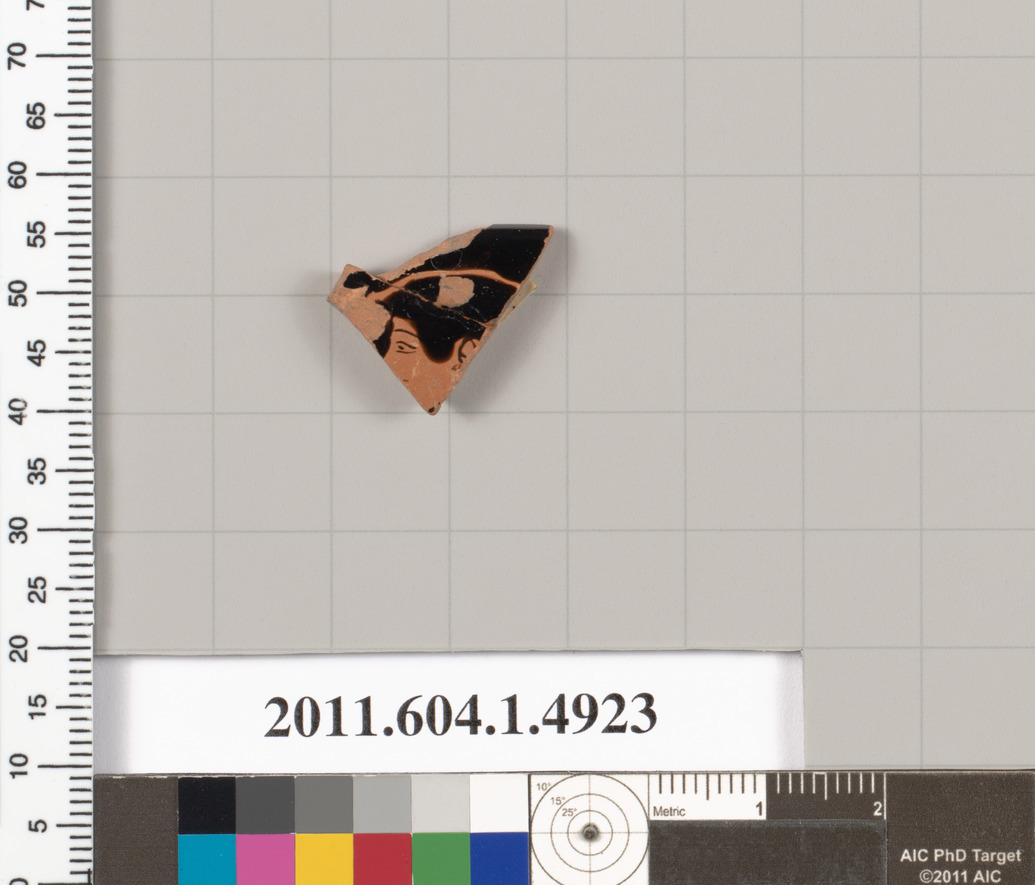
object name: kylix fragment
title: Terracotta rim fragment of a kylix (drinking cup)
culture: greek, attic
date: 480-470 BCE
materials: terracotta